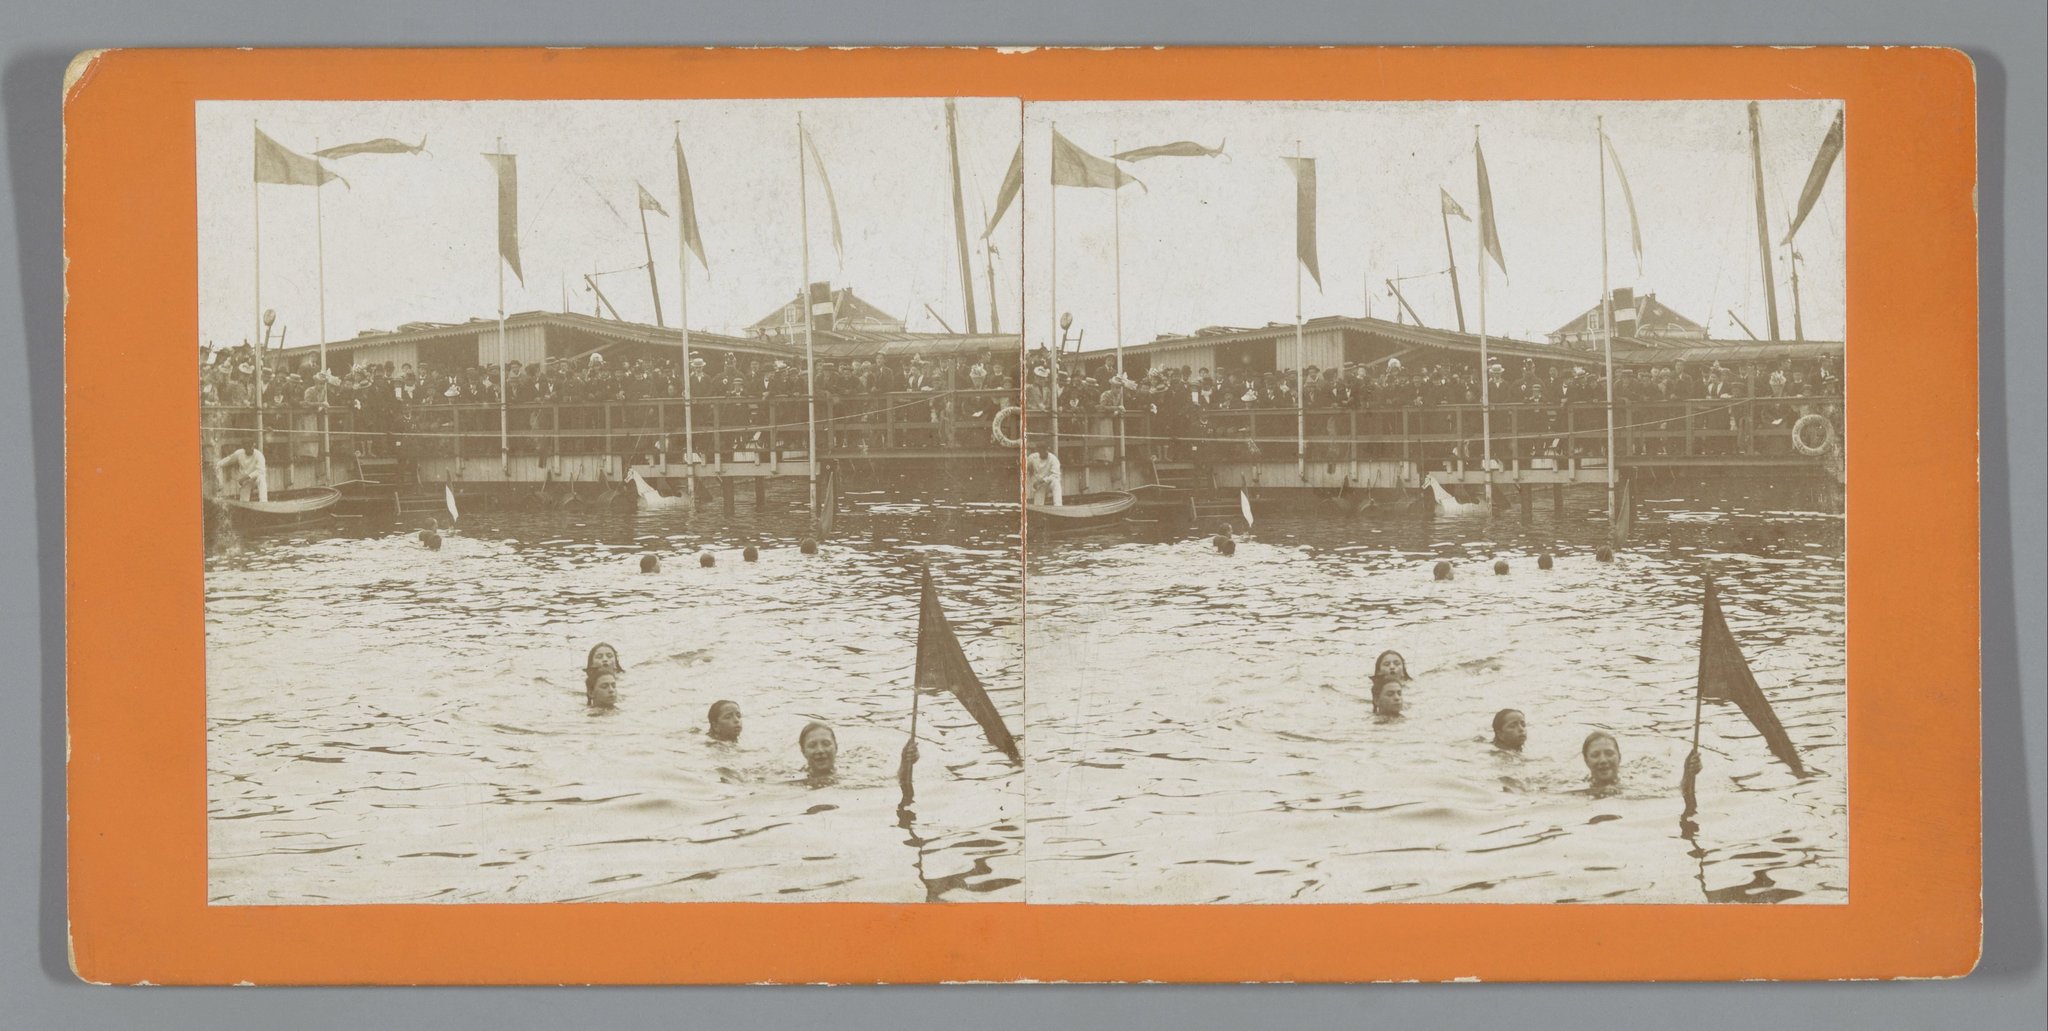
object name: stereograph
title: Zwemwedstrijd, deelnemers en toeschouwers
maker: Anonymous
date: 1868-1890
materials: paper, cardboard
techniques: collodion silver print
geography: netherlands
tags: swimming (sport), netherlands